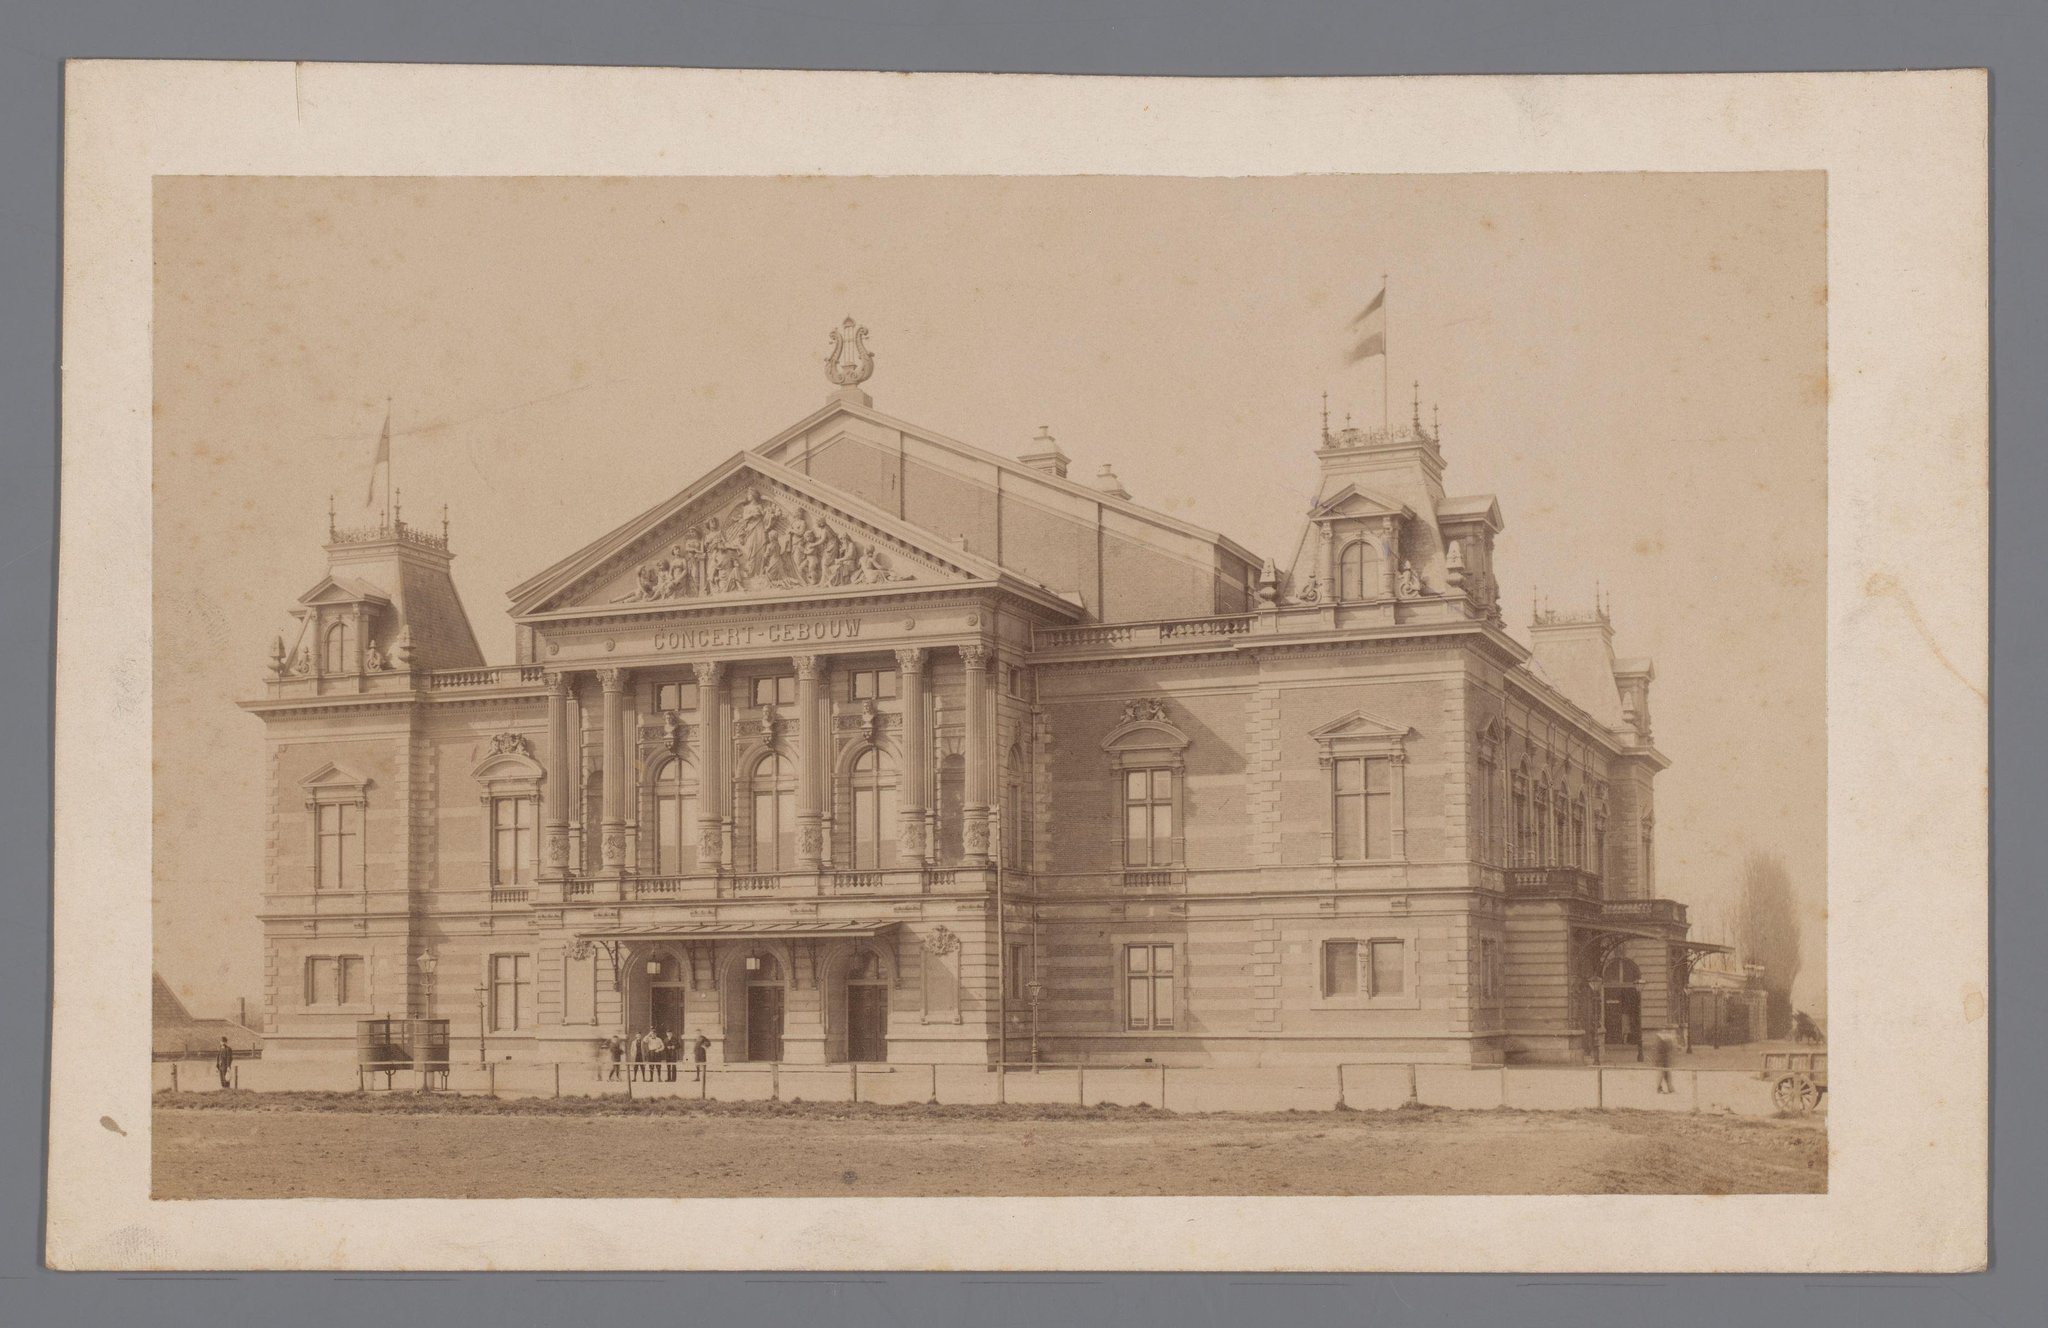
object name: photograph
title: Concertgebouw, Amsterdam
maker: Anonymous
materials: photographic support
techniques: gelatin silver print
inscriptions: number: ‘75.’, annotation: ‘160....[onleesbaar woord]’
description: Concertgebouw, Amsterdam, gezien van rechts voor, hele gebouw staat op foto. Een aantal figuren poseren voor het gebouw.